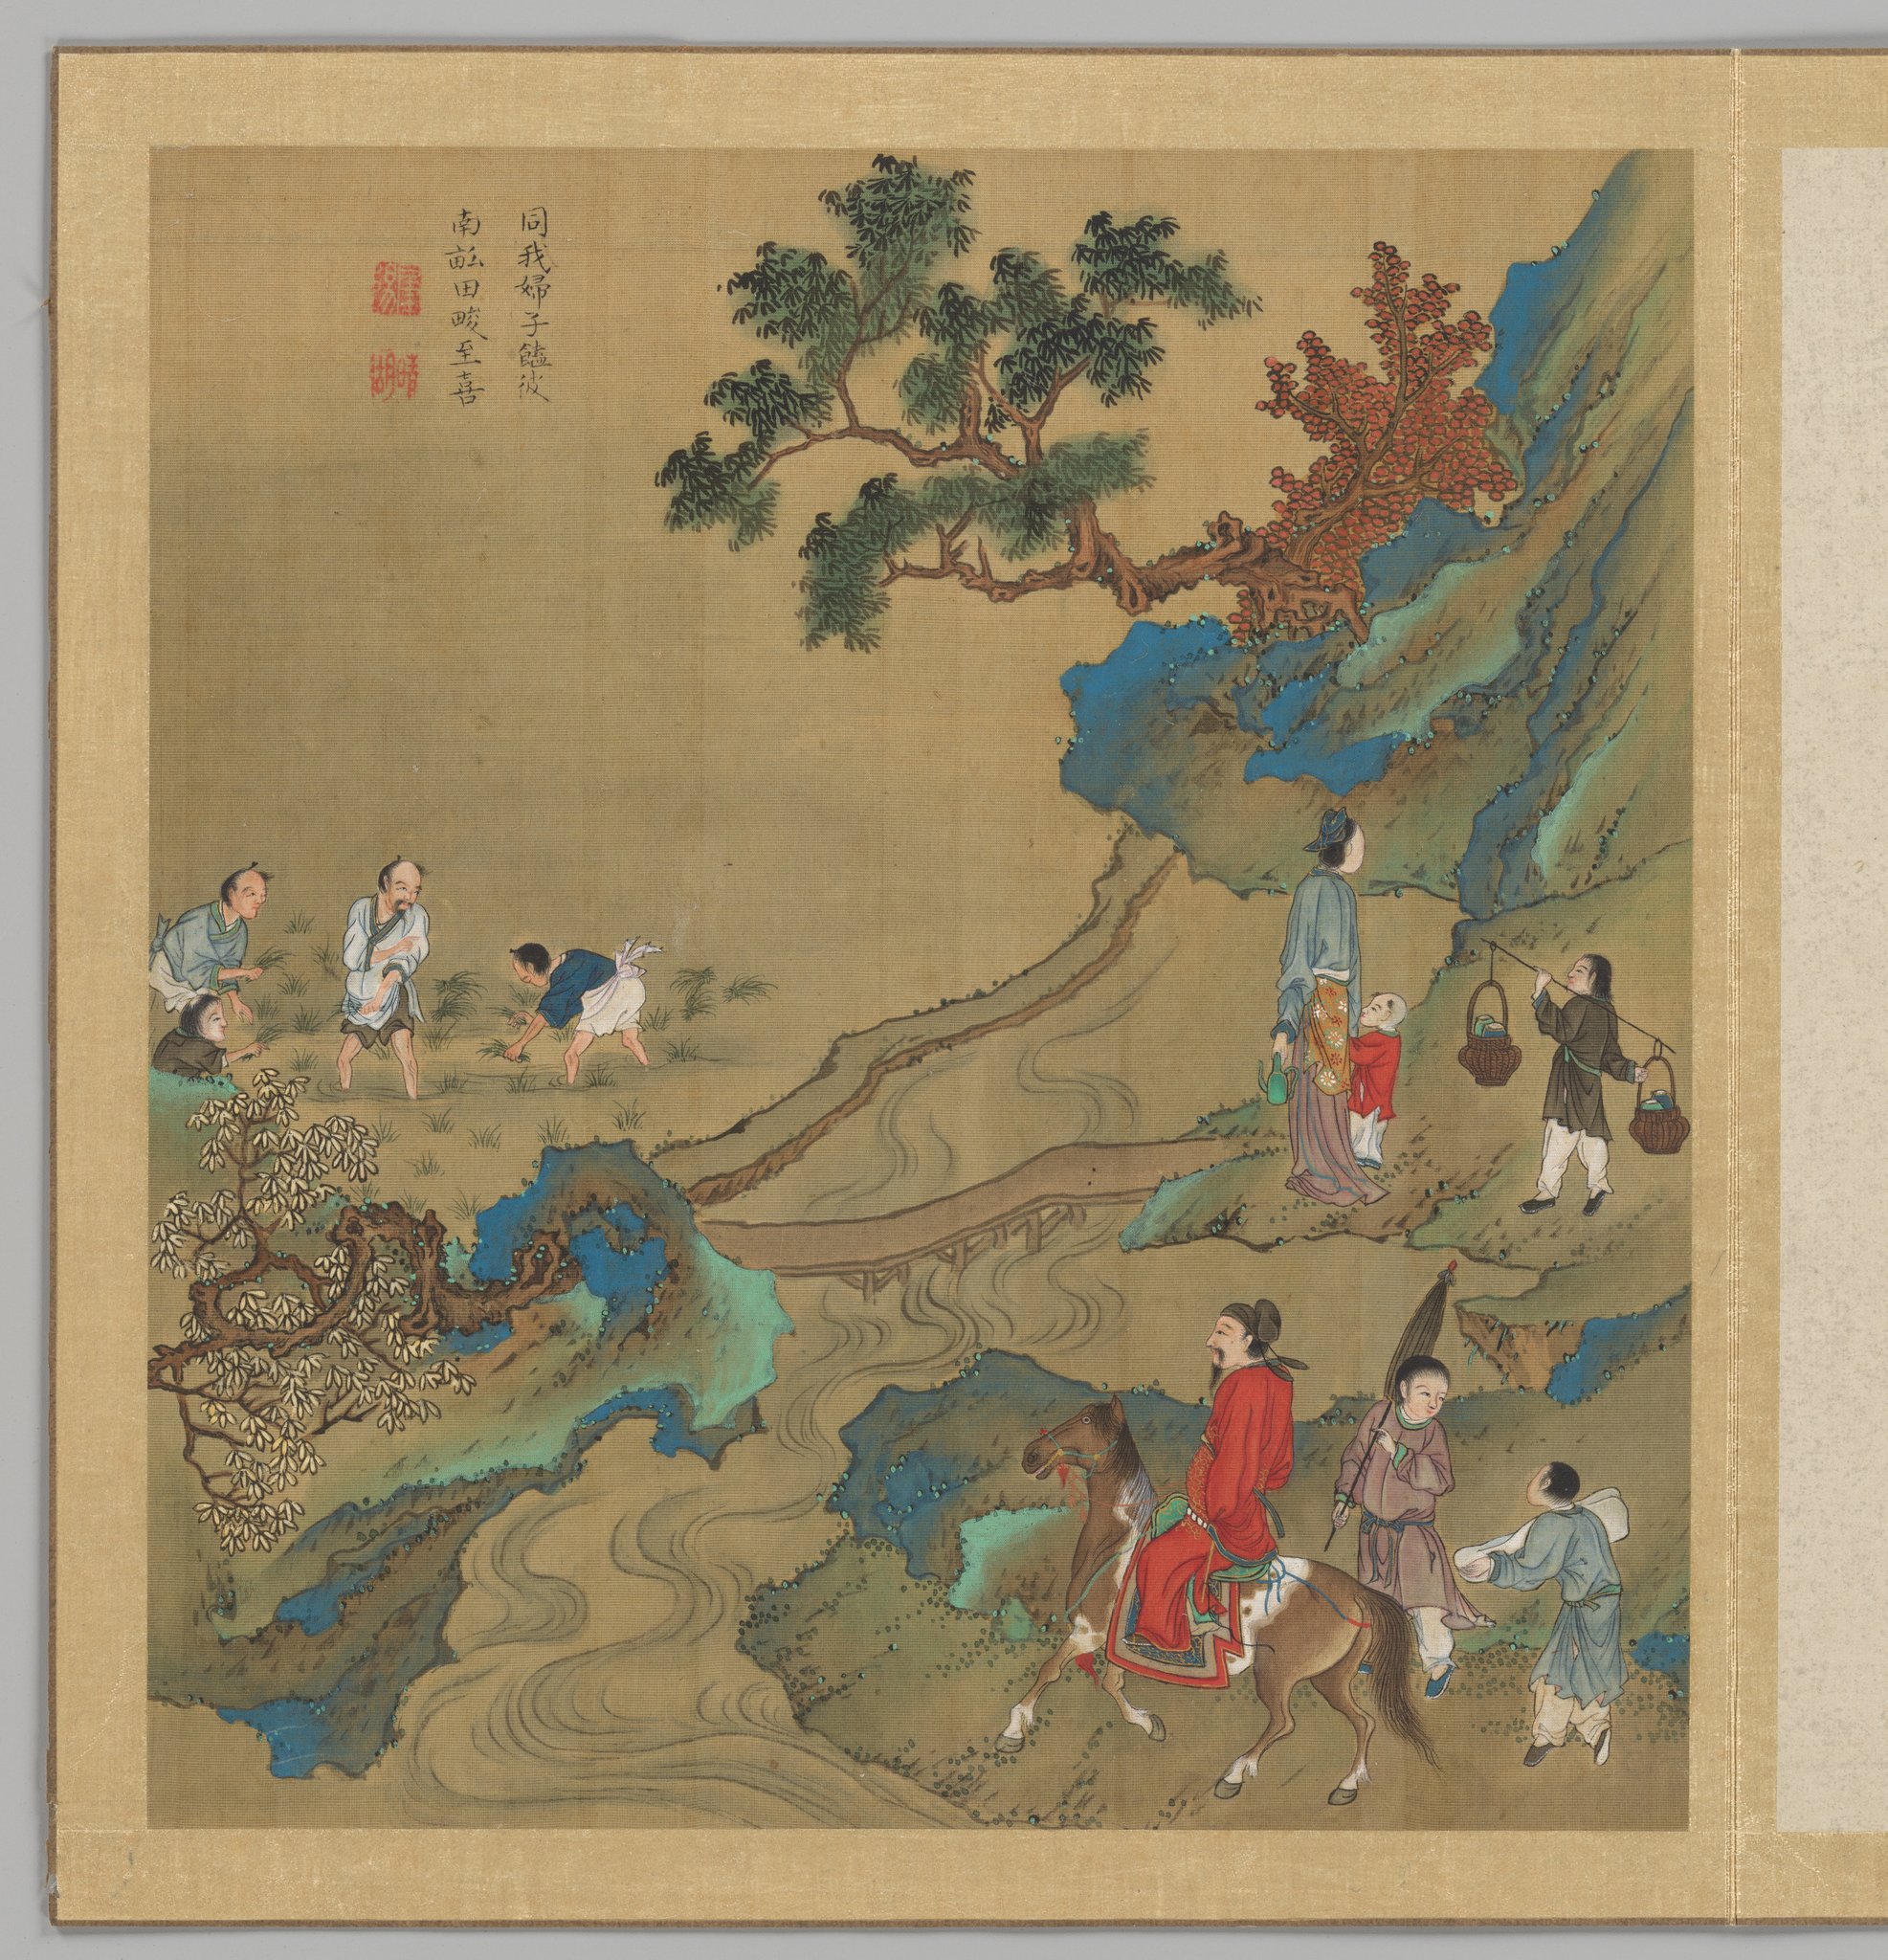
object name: album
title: Odes of the State of Bin: The Seventh Month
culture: chinese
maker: fei qinghu (fei zhaoyang)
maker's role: artist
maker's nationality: chinese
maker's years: 1768-1833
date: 1767-1833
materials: ink, silk